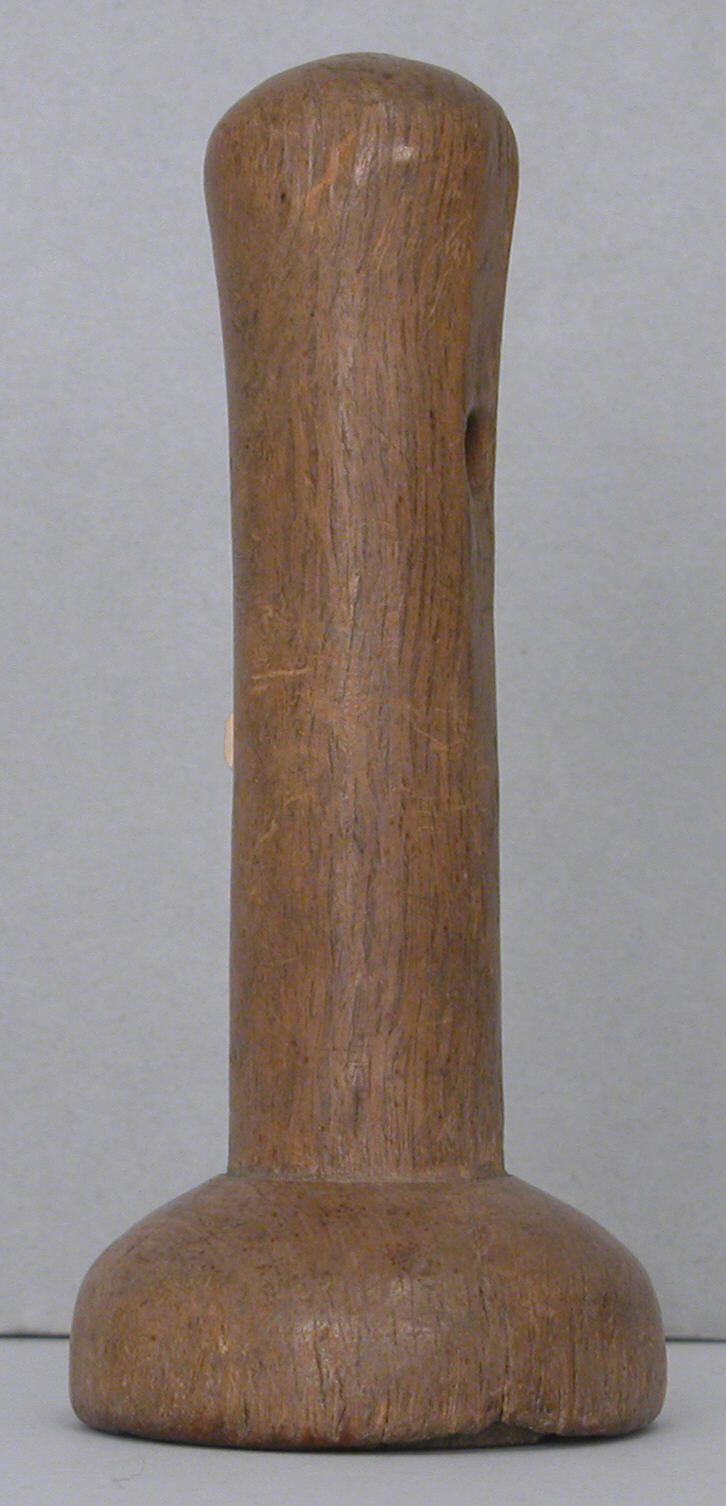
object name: stamp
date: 1101-1900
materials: wood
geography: egypt